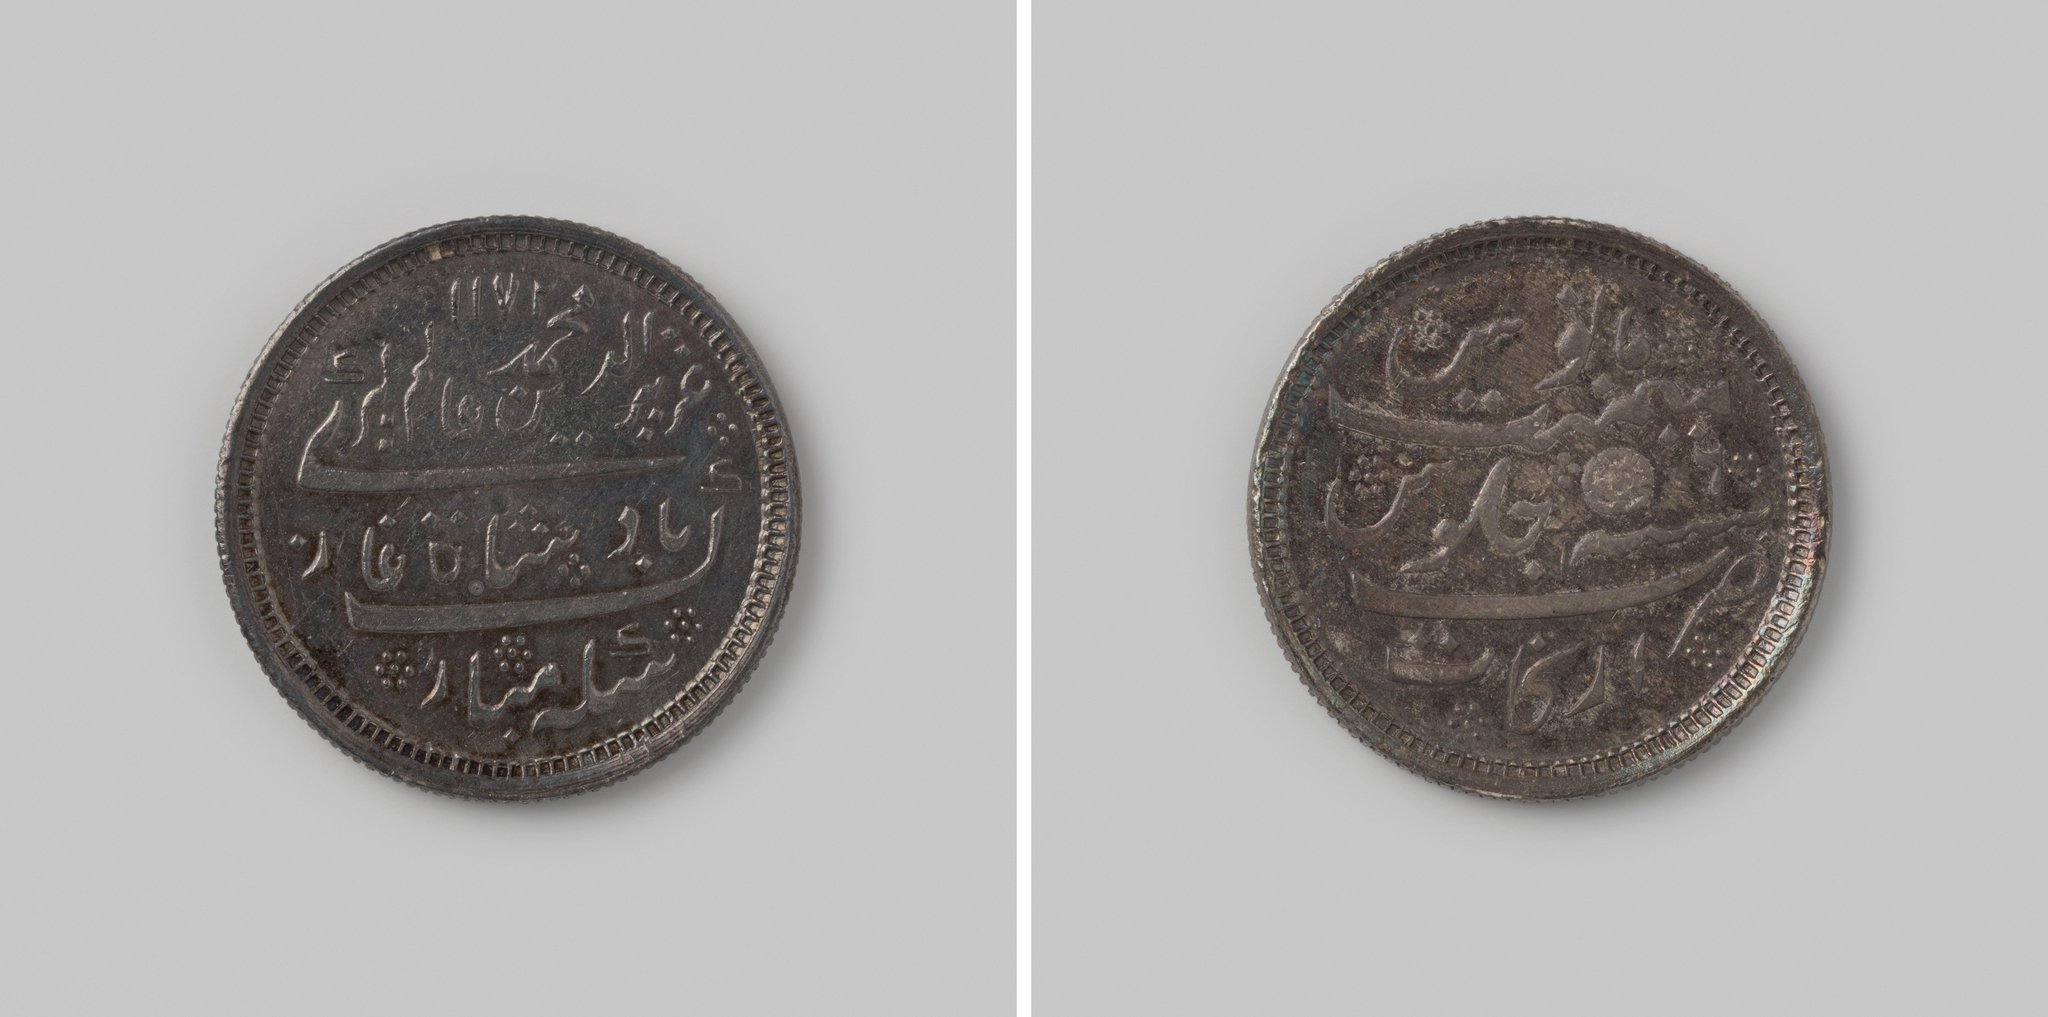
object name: coin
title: ½ Arkot-roepie voor Madras in India van de Engelse Oostindische Compagnie (EIC) op naam van sjah Alamgir II,1172 [=1759]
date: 1823-1825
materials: silver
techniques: striking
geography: kolkata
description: Zilveren munt. Voorzijde: in Arabische lettertekens in drie regels opschrift met bovenaan aanduiding jaartal: 1172. Keerzijde: in Arabische lettertekens in drie regels opschrift. Boven tweede regel aanduiding regeringsjaar: 6 met links daarvan rozet [=muntplaats Calcutta]. Geslagen in de jaren 1823-1825 te Calcutta. Kartelrand.